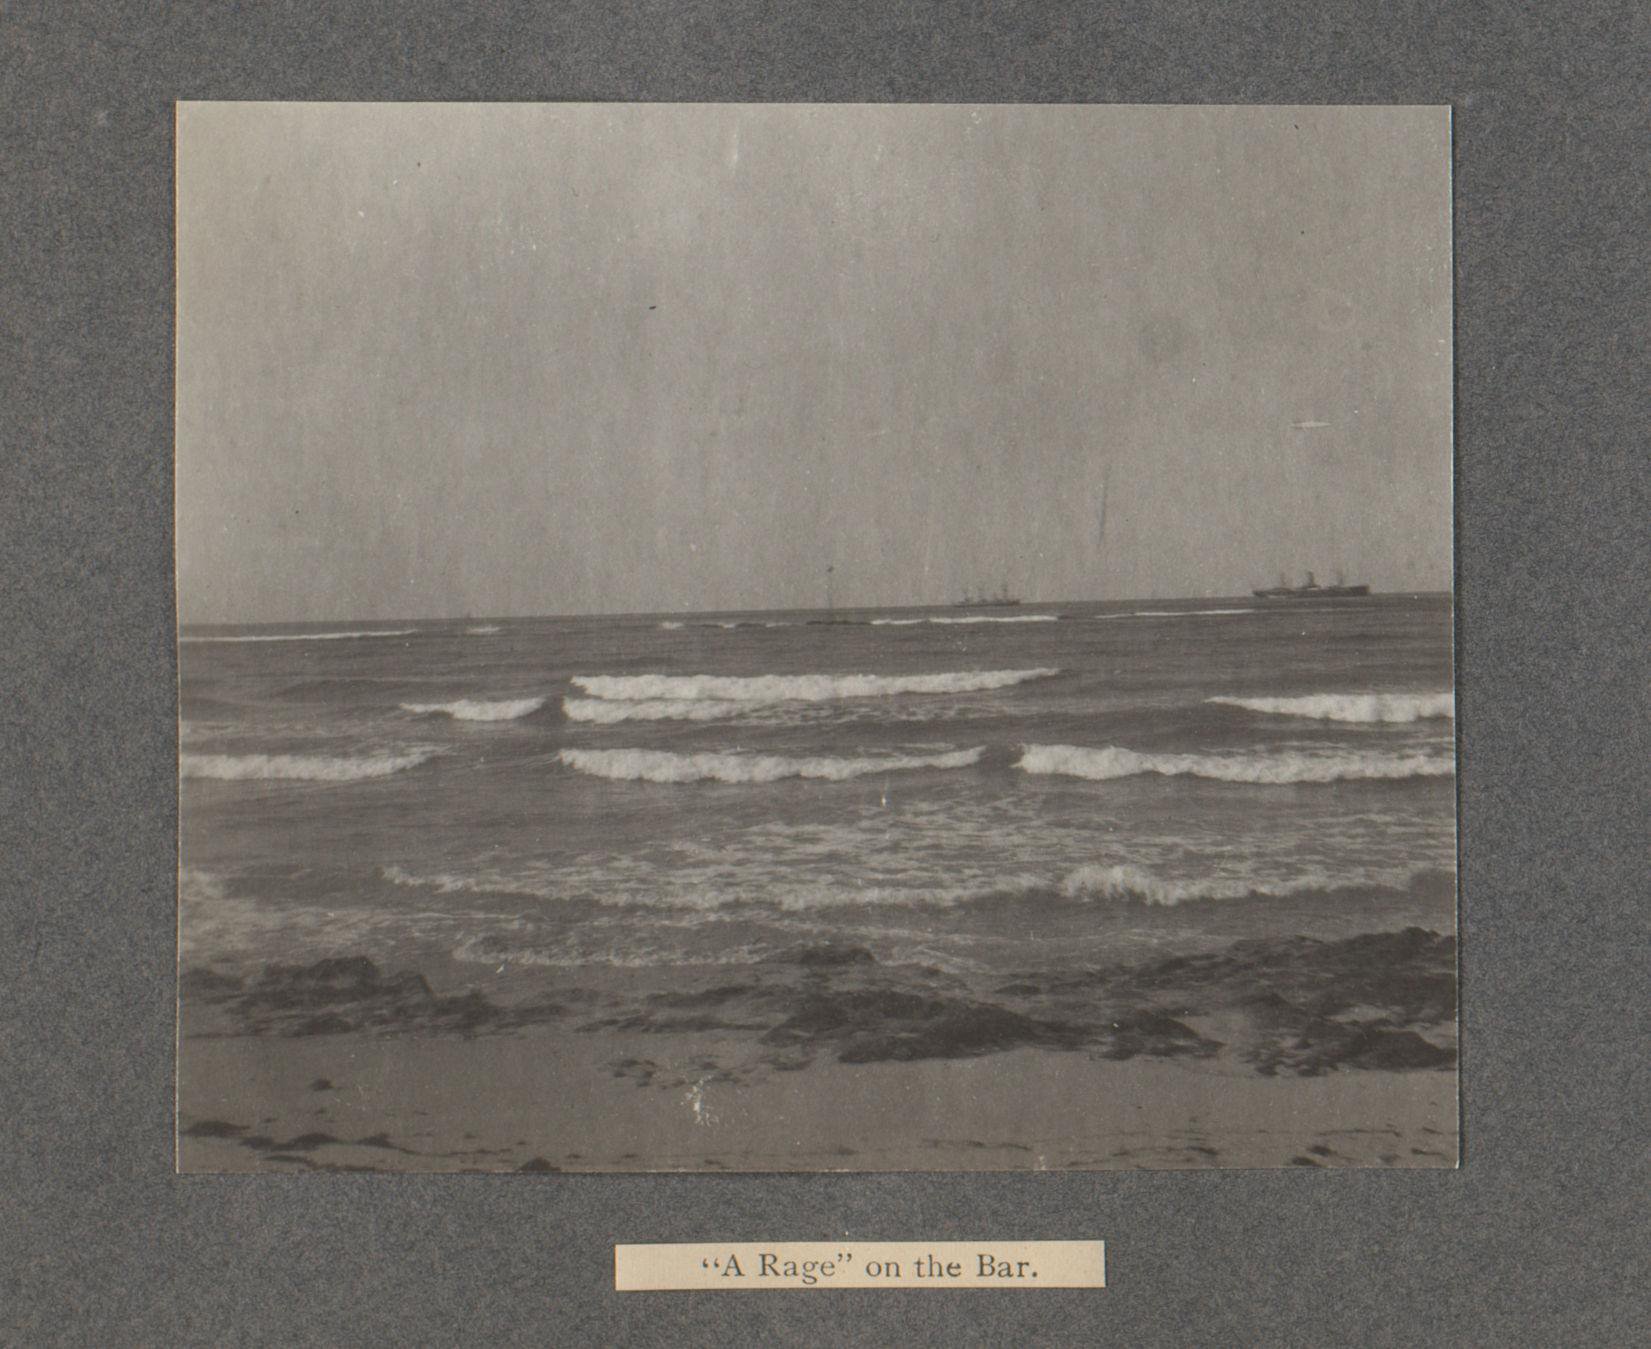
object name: album leaf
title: "A Rage" on the Bar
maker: Anonymous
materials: paper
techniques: platinum process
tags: ships (in general), coast